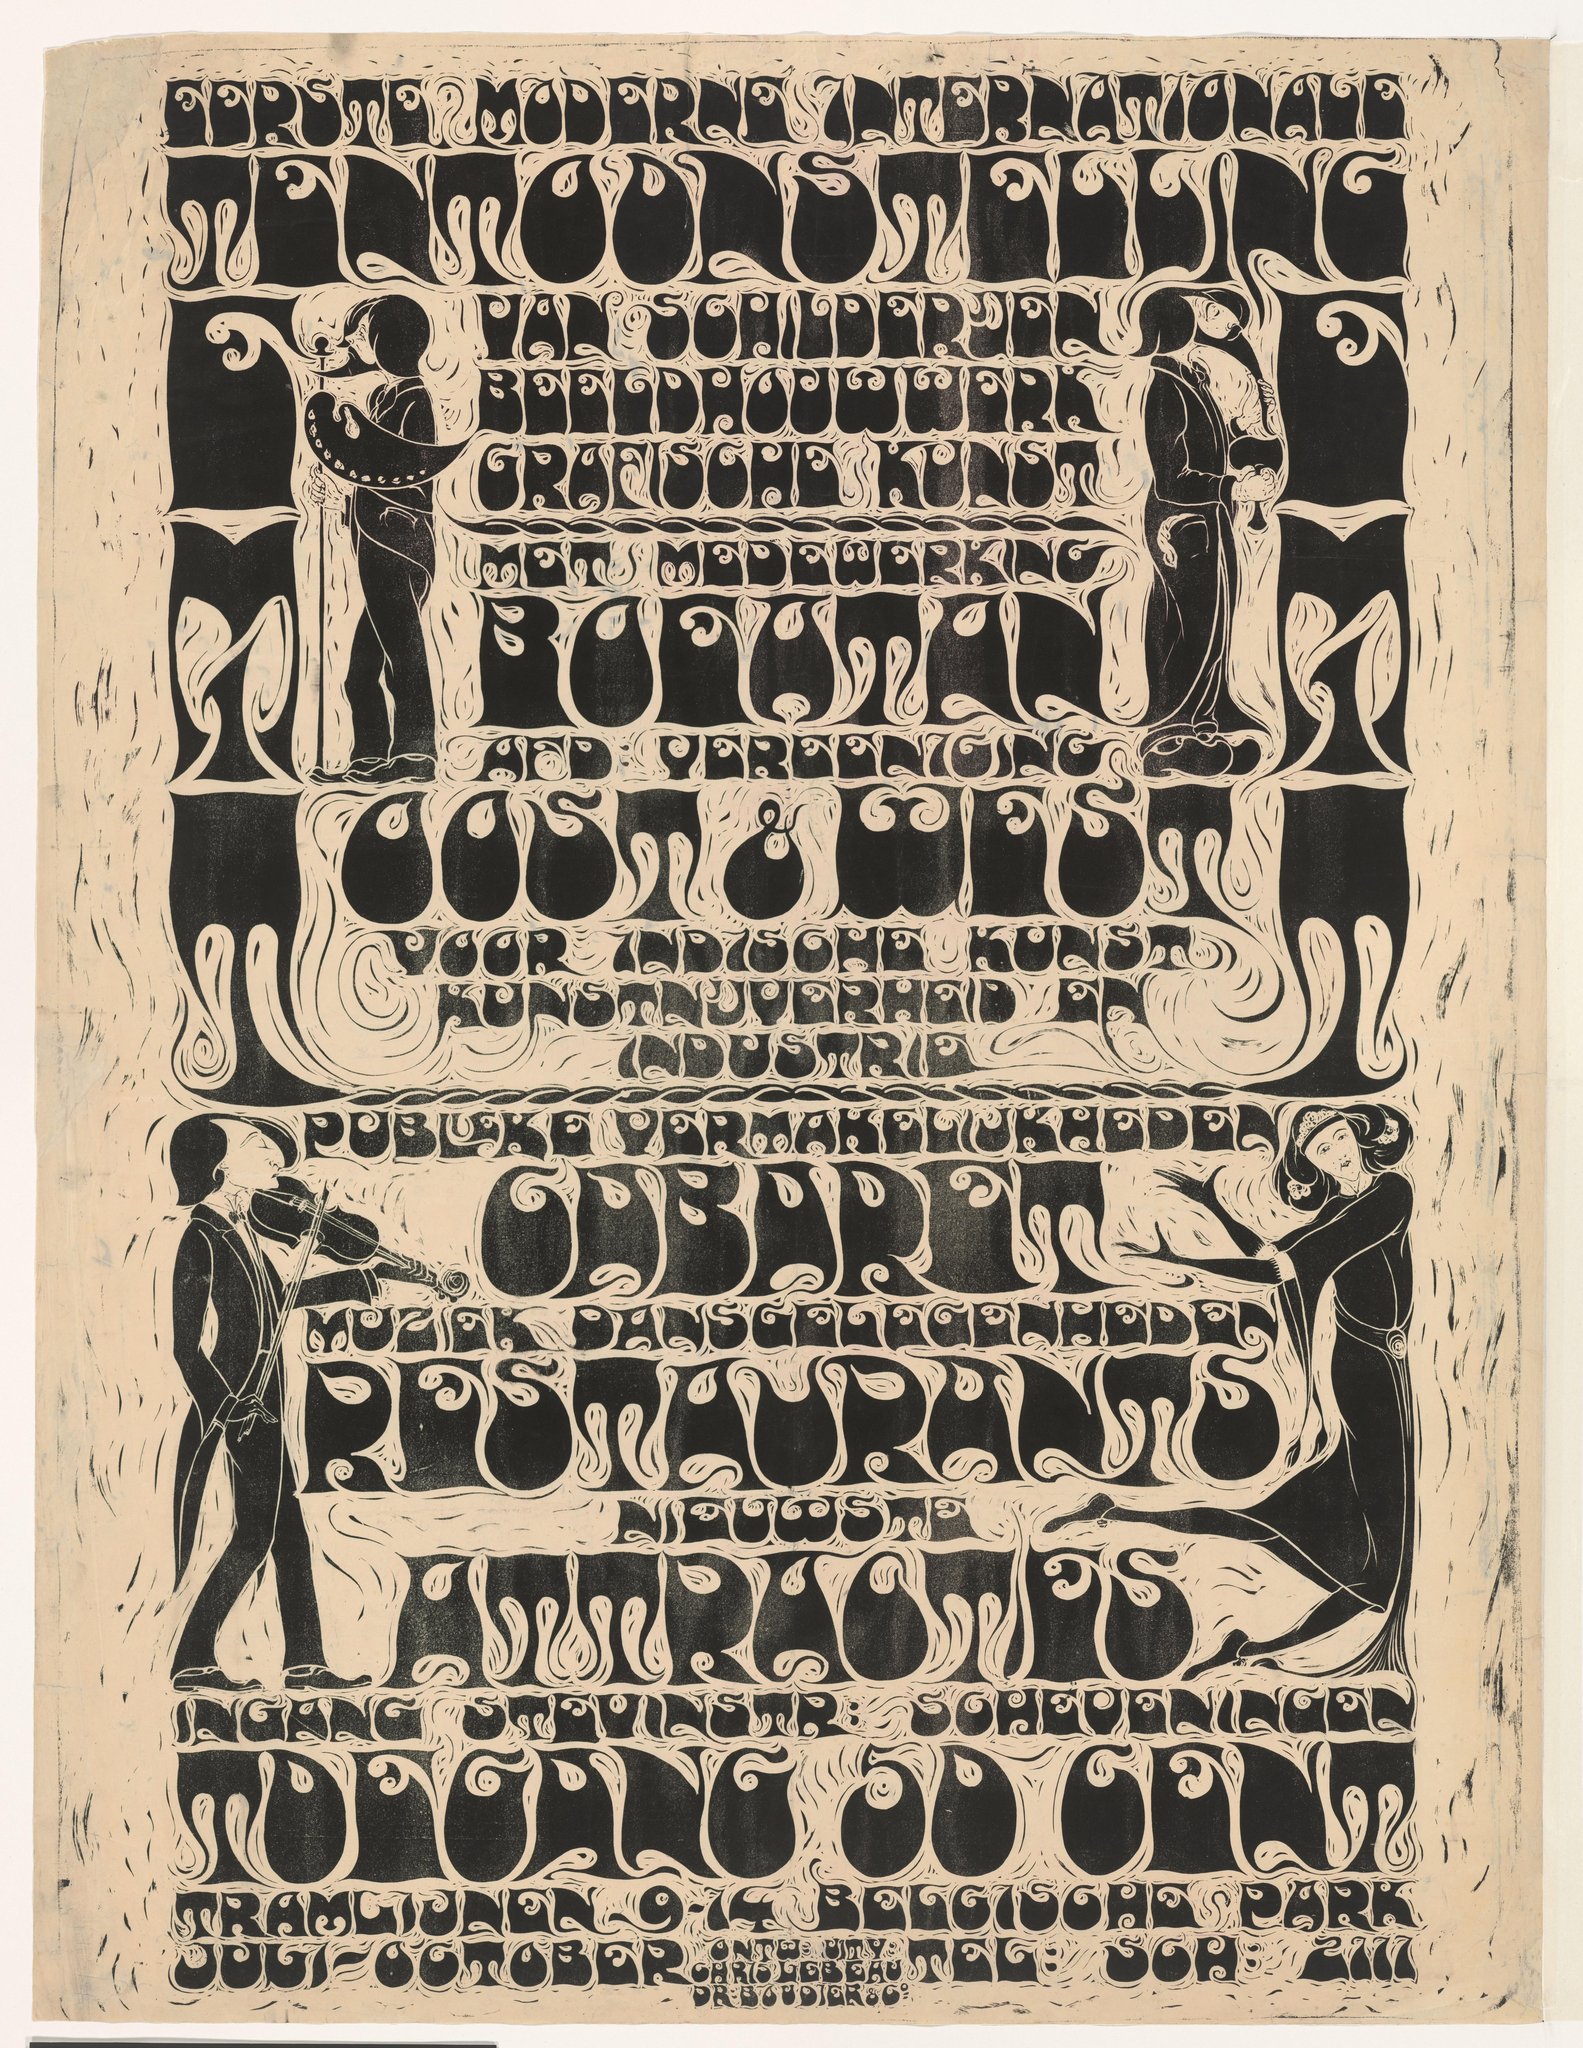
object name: poster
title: Eerste Moderne Internationale Tentoonstelling van schilderijen beeldhouwwerk grafische kunst met medewerking Boeatan afd. Vereeniging Oost & West voor Indische kunst kunsthijverheid en industrie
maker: chris lebeau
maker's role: draughtsman, print maker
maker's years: 1878-1945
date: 1923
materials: paper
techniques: lithograph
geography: the hague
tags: musician, violin, fiddle, female dancer, painter in non-work situation, sculptor in non-work situation, exhibition ~ art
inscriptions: collector's mark: Lugt 2228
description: Tussen de letters vier figuren: linksboven een schilder met palet, rechtsboven een beeldhouwer, linksonder een violist en rechtsonder een danseres.